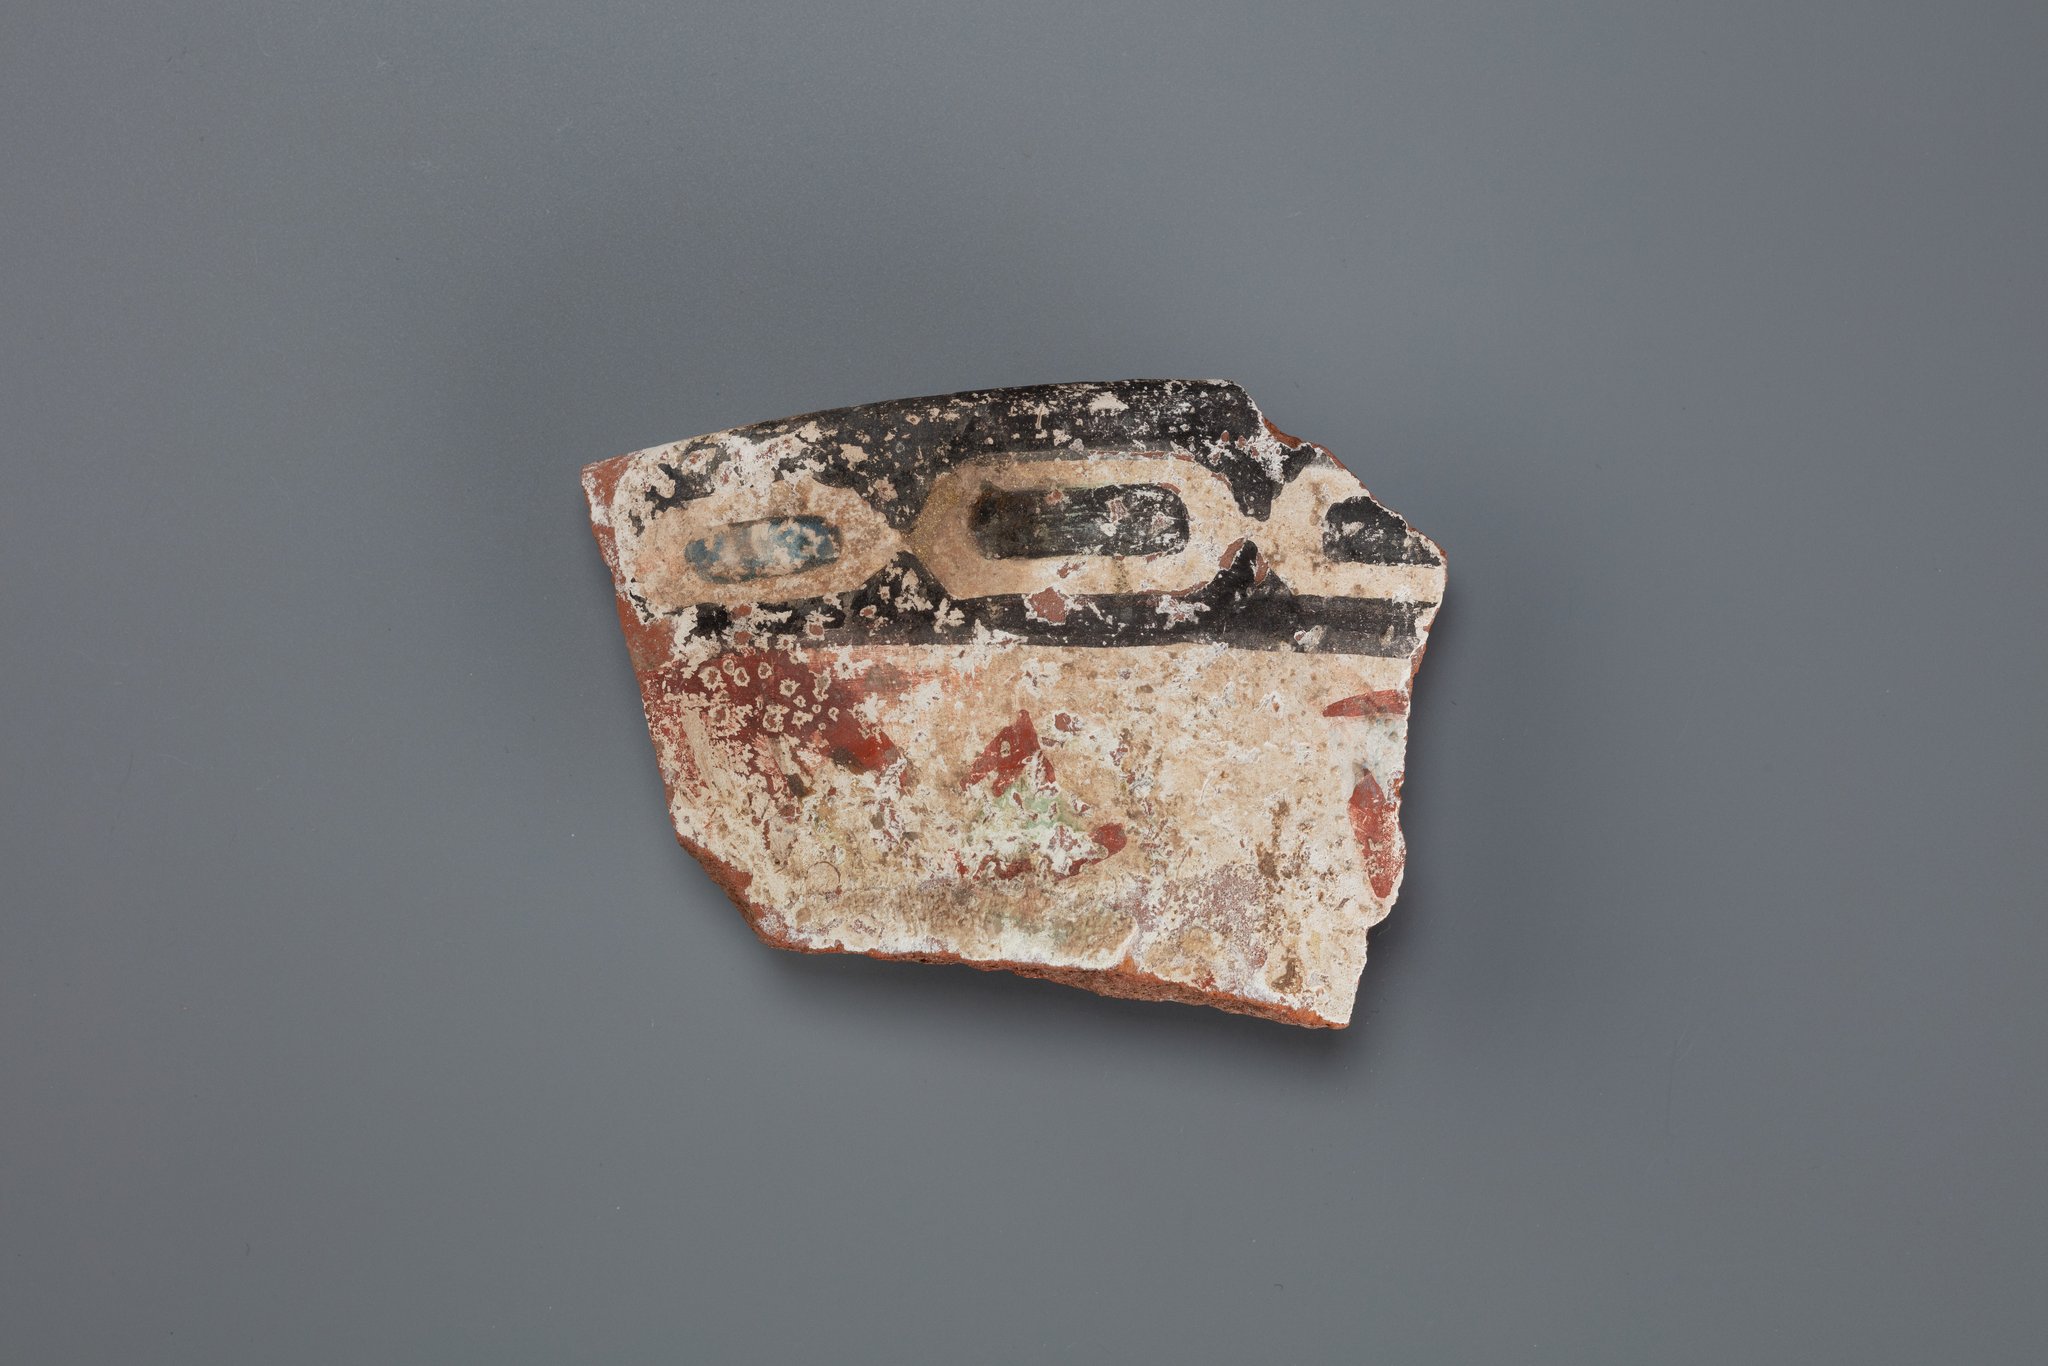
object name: jar fragment, inscribed, malqata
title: Decorated jar fragment with inscription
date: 1390-1352 BCE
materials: ink, paint, pottery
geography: egypt